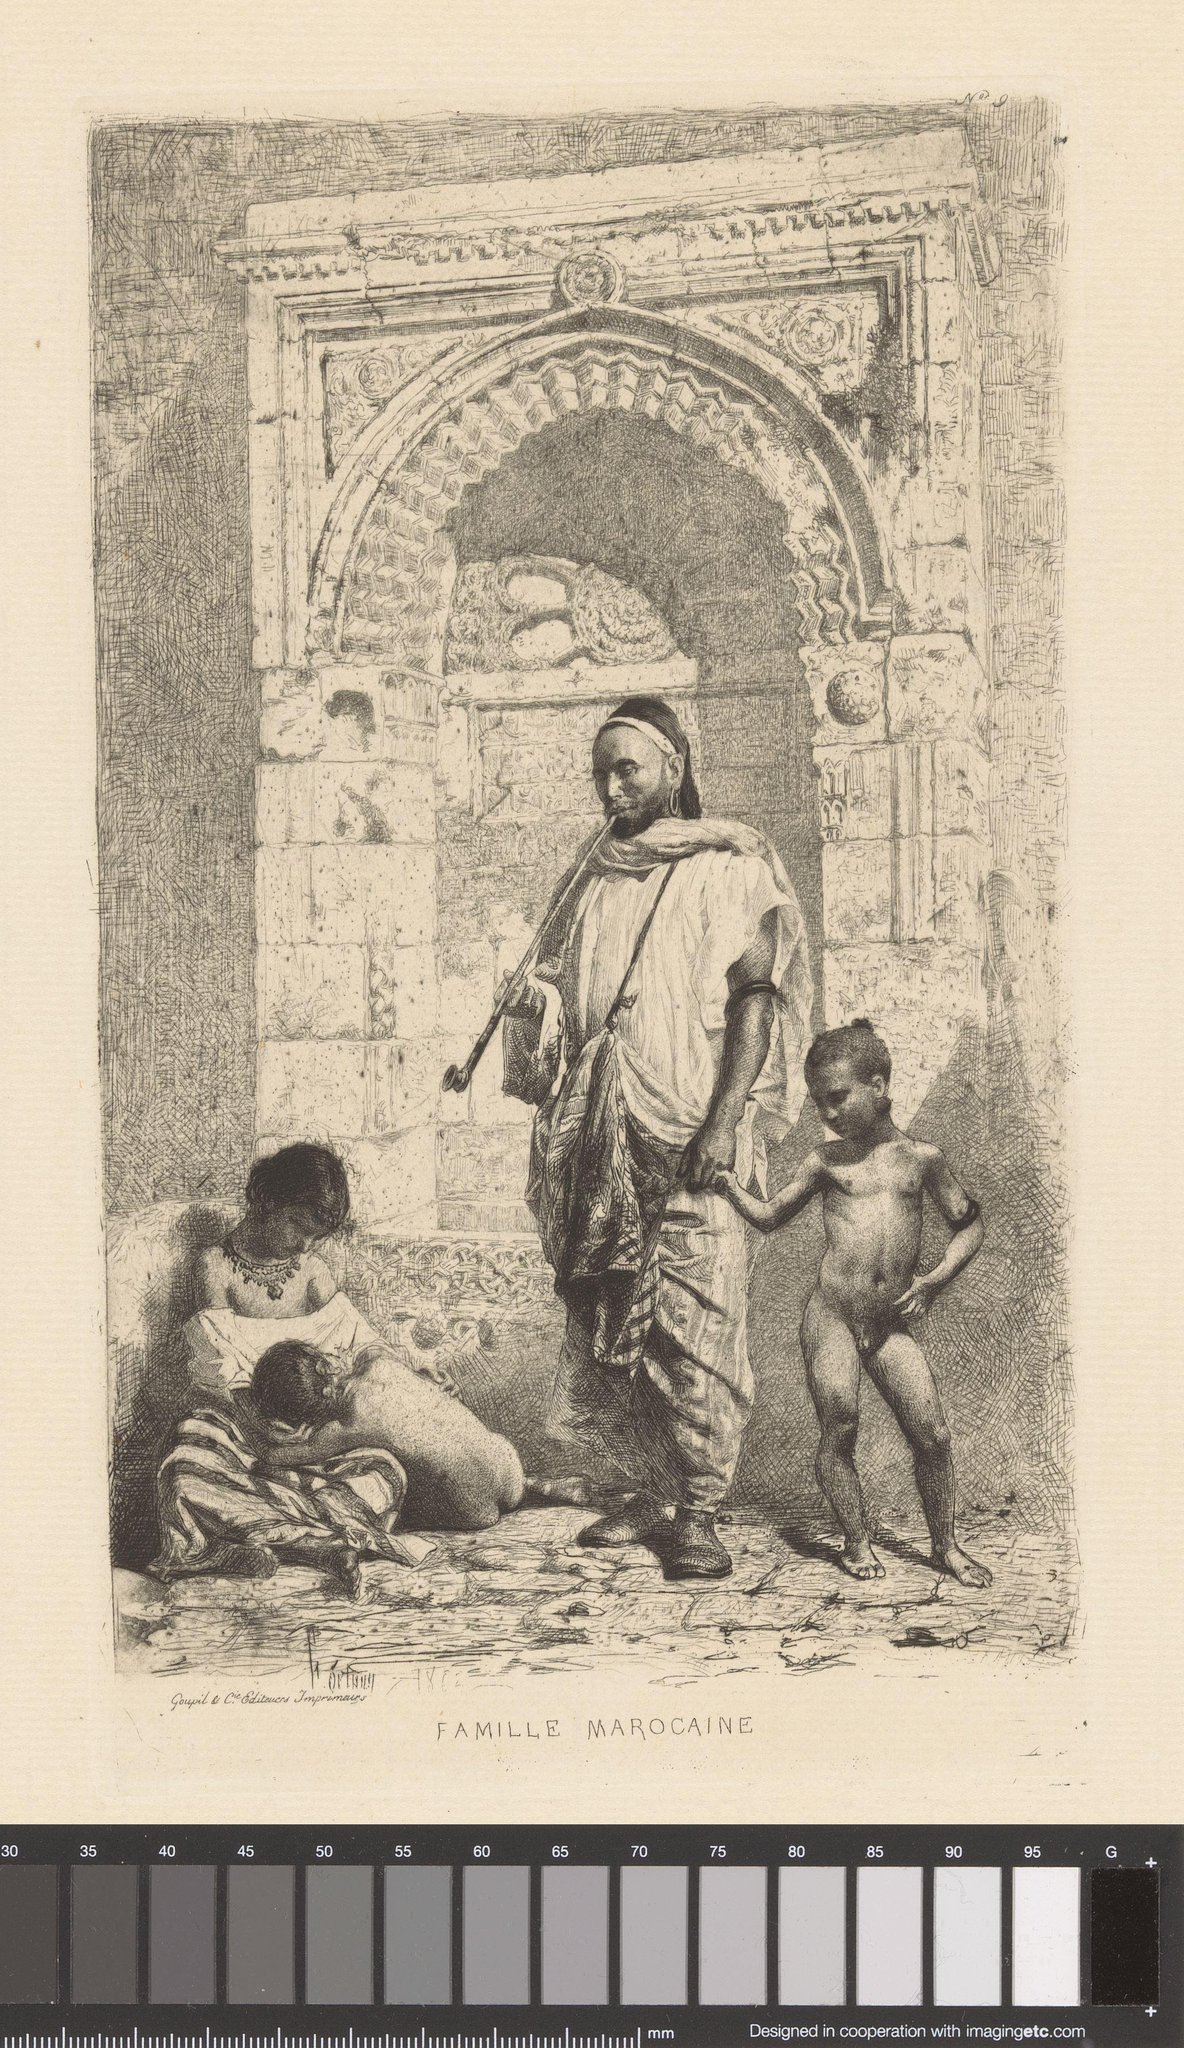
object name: print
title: Familie voor een fontein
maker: mariano josé maria bernardo fortuny y carbó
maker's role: painter, print maker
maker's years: 1838-1874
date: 1862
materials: paper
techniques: etching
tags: (showing oneself) undressed, quasi-nude, parents with their children, pipe ~ tobacco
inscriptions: collector's mark: Lugt 2228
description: Voor een fontein staat een pijprokende man. Hij houdt de hand vast van een naakte jongen die naast hem staat. Op de grond zit een jonge vrouw. Naast haar een naakt kind dat het hoofd in de schoot van de vrouw legt.